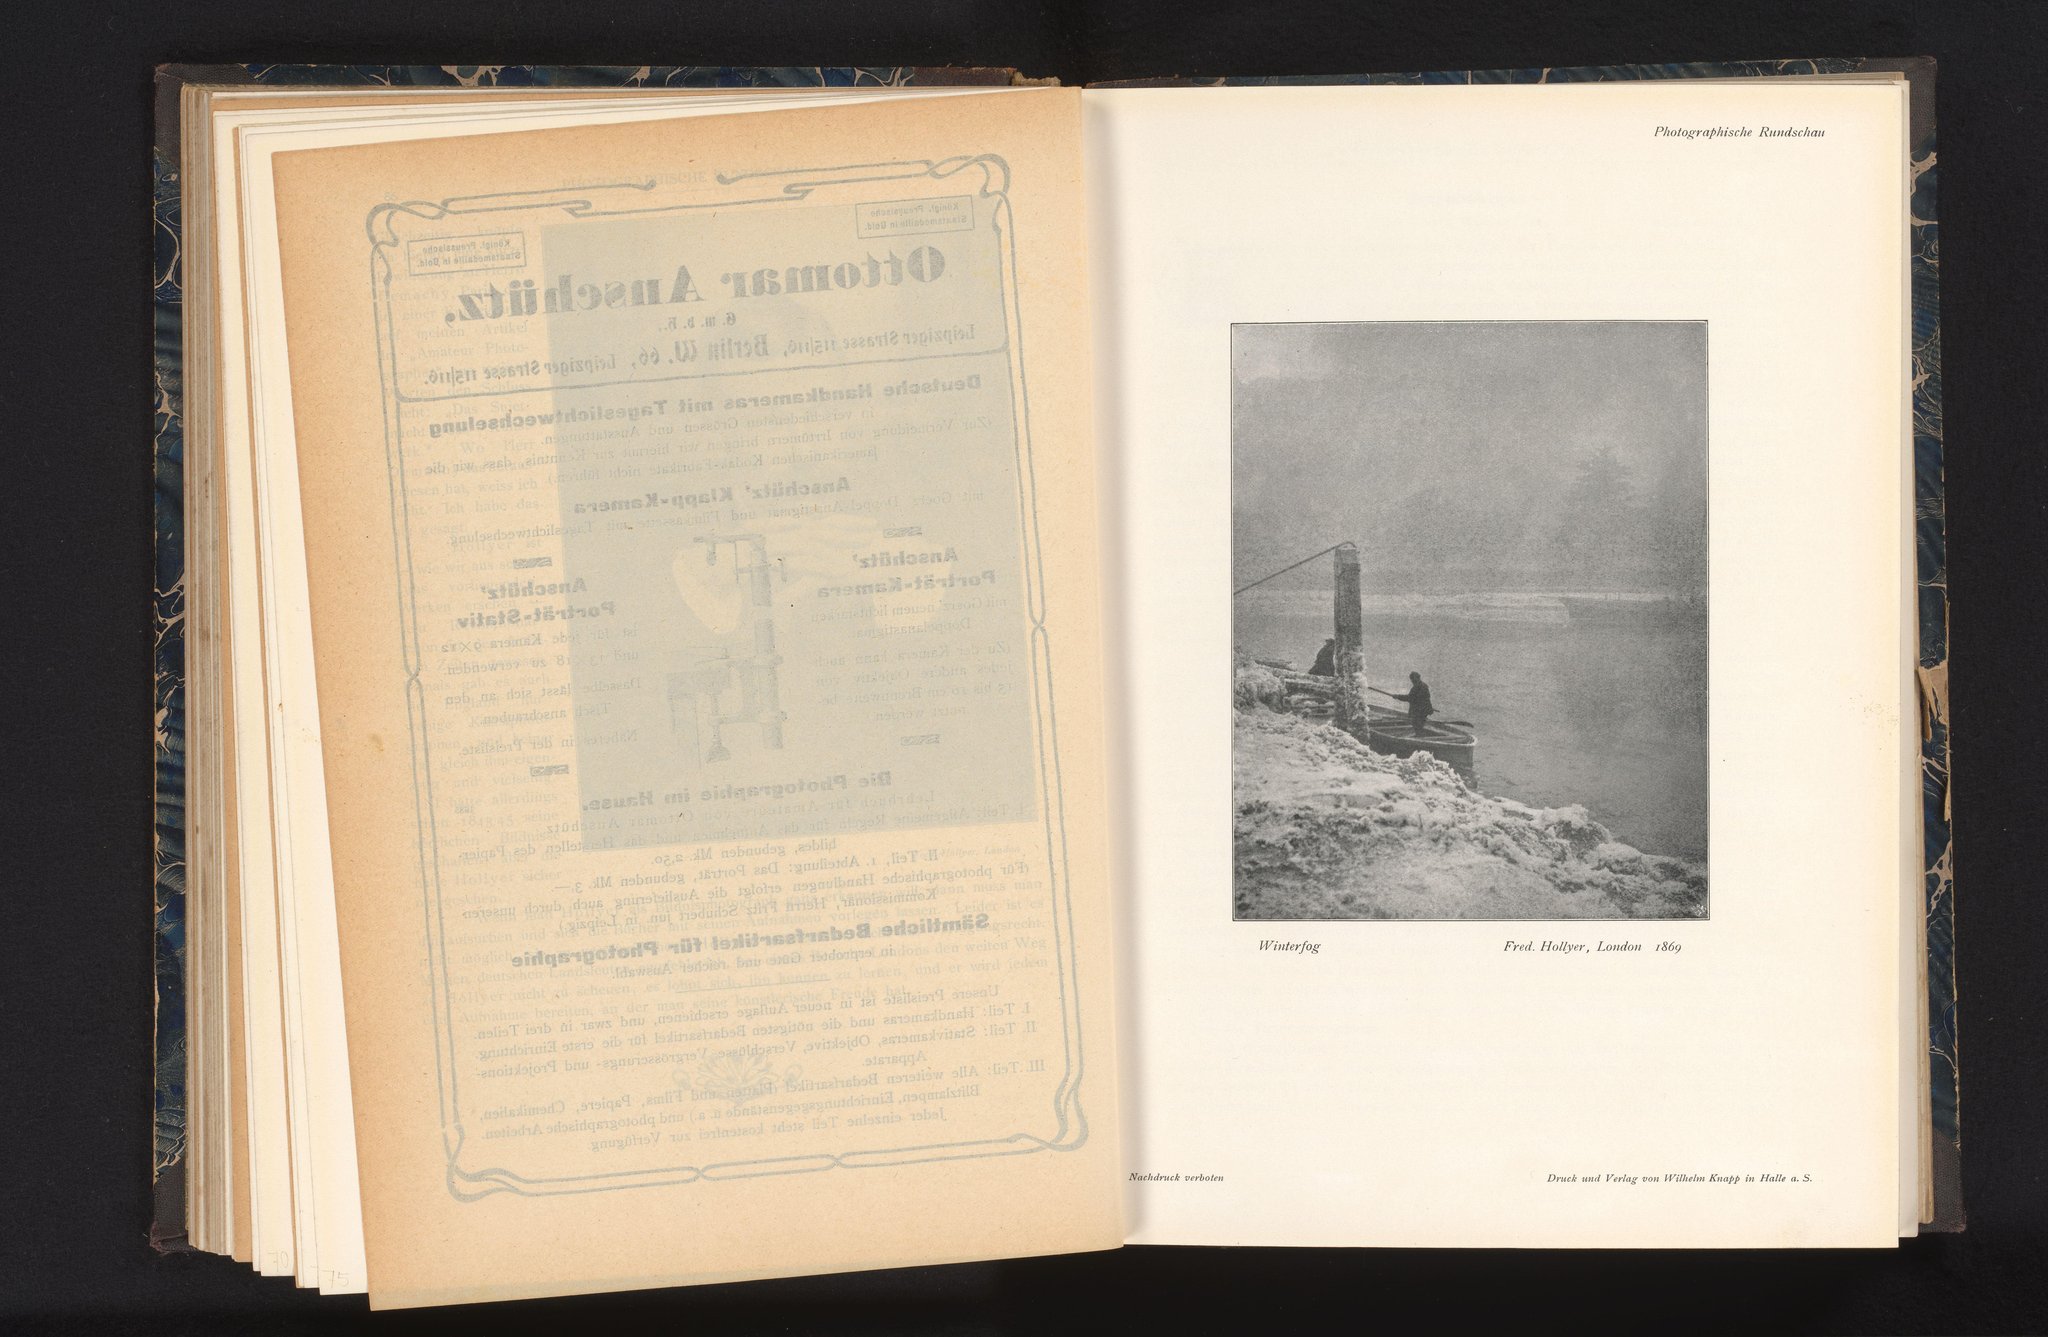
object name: photomechanical print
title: Gezicht op een onbekend persoon in een aangelegd bootje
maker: frederick hollyer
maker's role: fotograaf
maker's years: 1838-1933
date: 1869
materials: paper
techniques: autotype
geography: berlin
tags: landscapes with waters, waterscapes, seascapes (in the temperate zone), rowing-boat, canoe, etc.